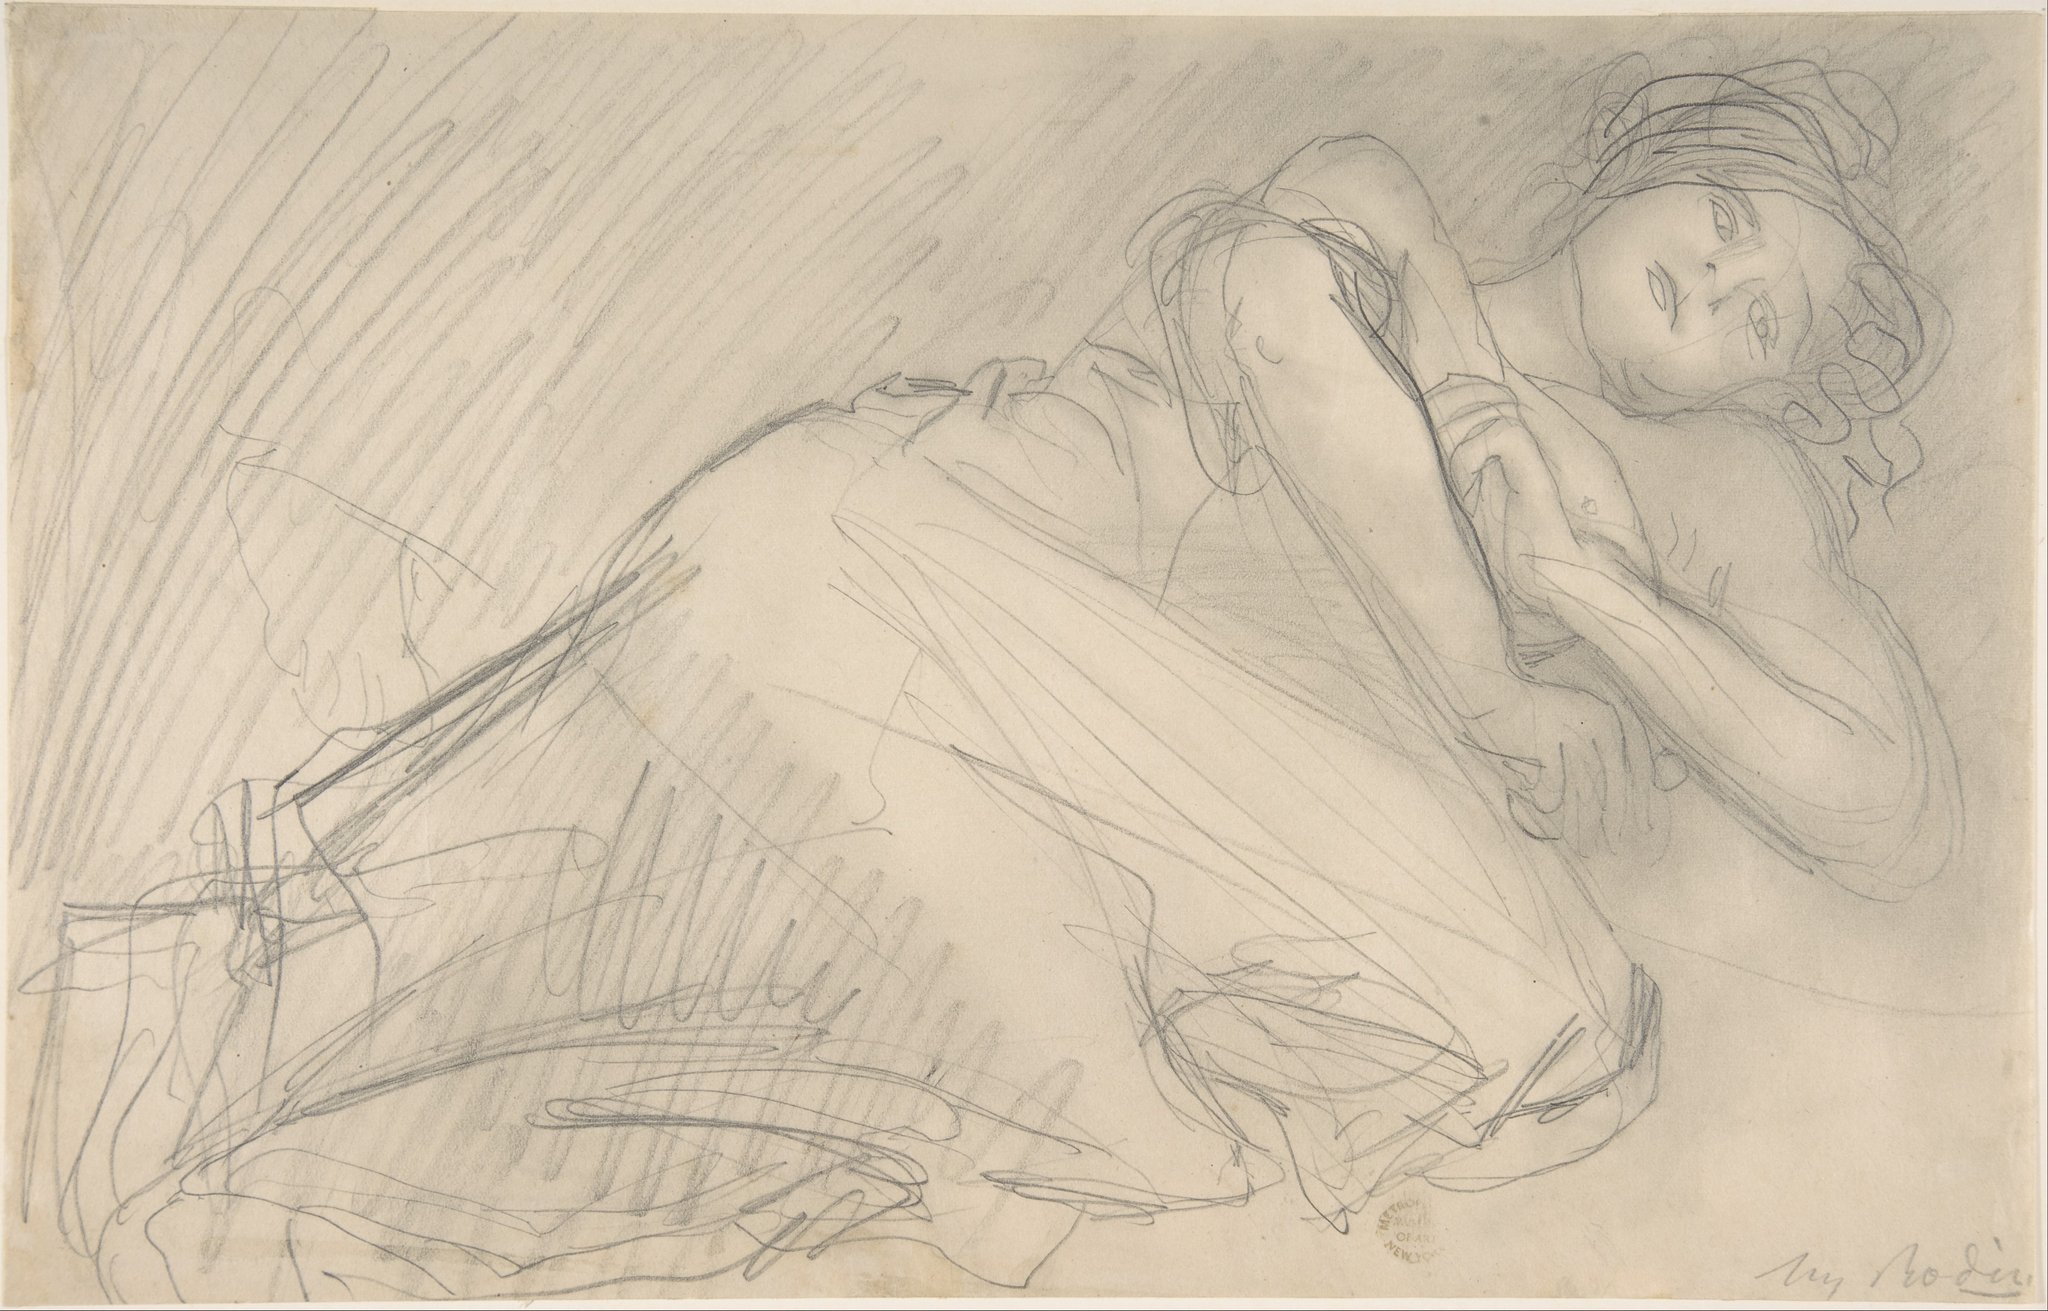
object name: drawing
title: The Abandoned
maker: auguste rodin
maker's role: artist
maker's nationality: french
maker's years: 1840-1917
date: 1902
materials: graphite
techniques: stumping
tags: women